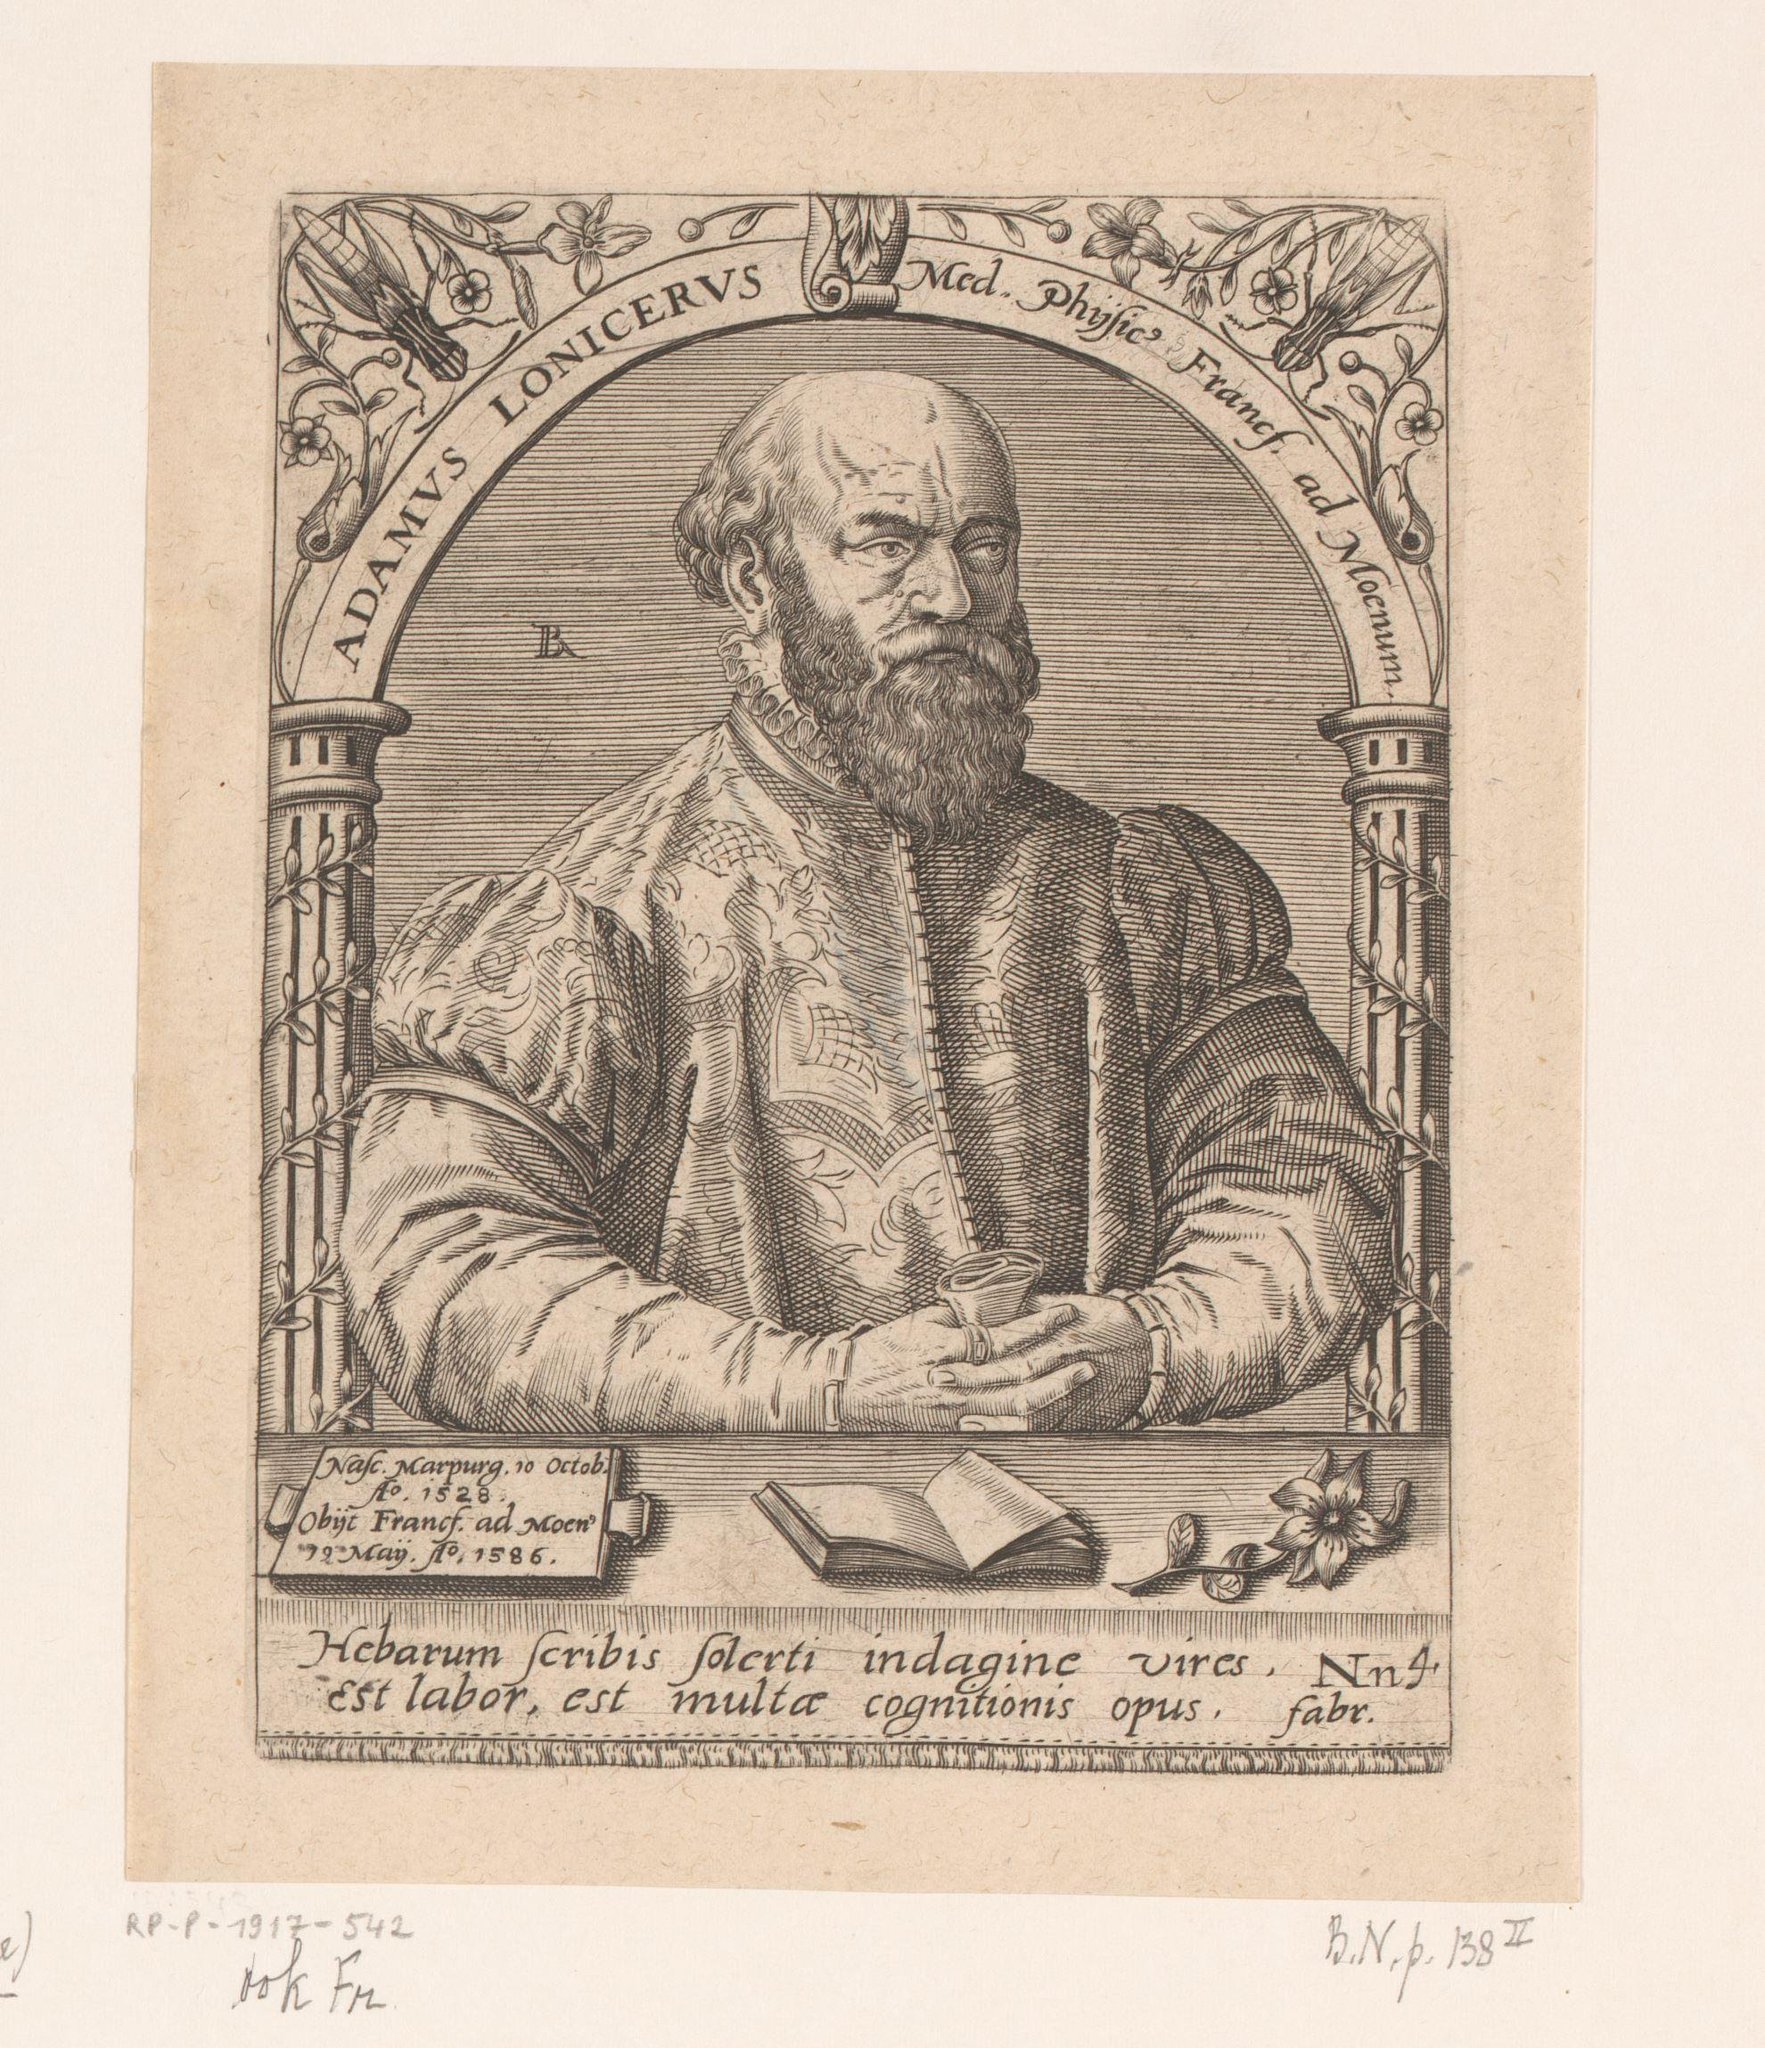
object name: print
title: Serie portretten van vijftiende- en zestiende-eeuwse geleerden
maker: robert boissard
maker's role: print maker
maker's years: 1570-1611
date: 1597-1599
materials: paper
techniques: engraving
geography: france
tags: physicist, flowers ~ ornament - aa - stylized, insects: grass-hopper - ff - fabulous animals (sometimes wrongly called 'grotesques'; 'mostri' (ripa), historical persons, armorial bearing, heraldry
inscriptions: collector's mark: Lugt 2228